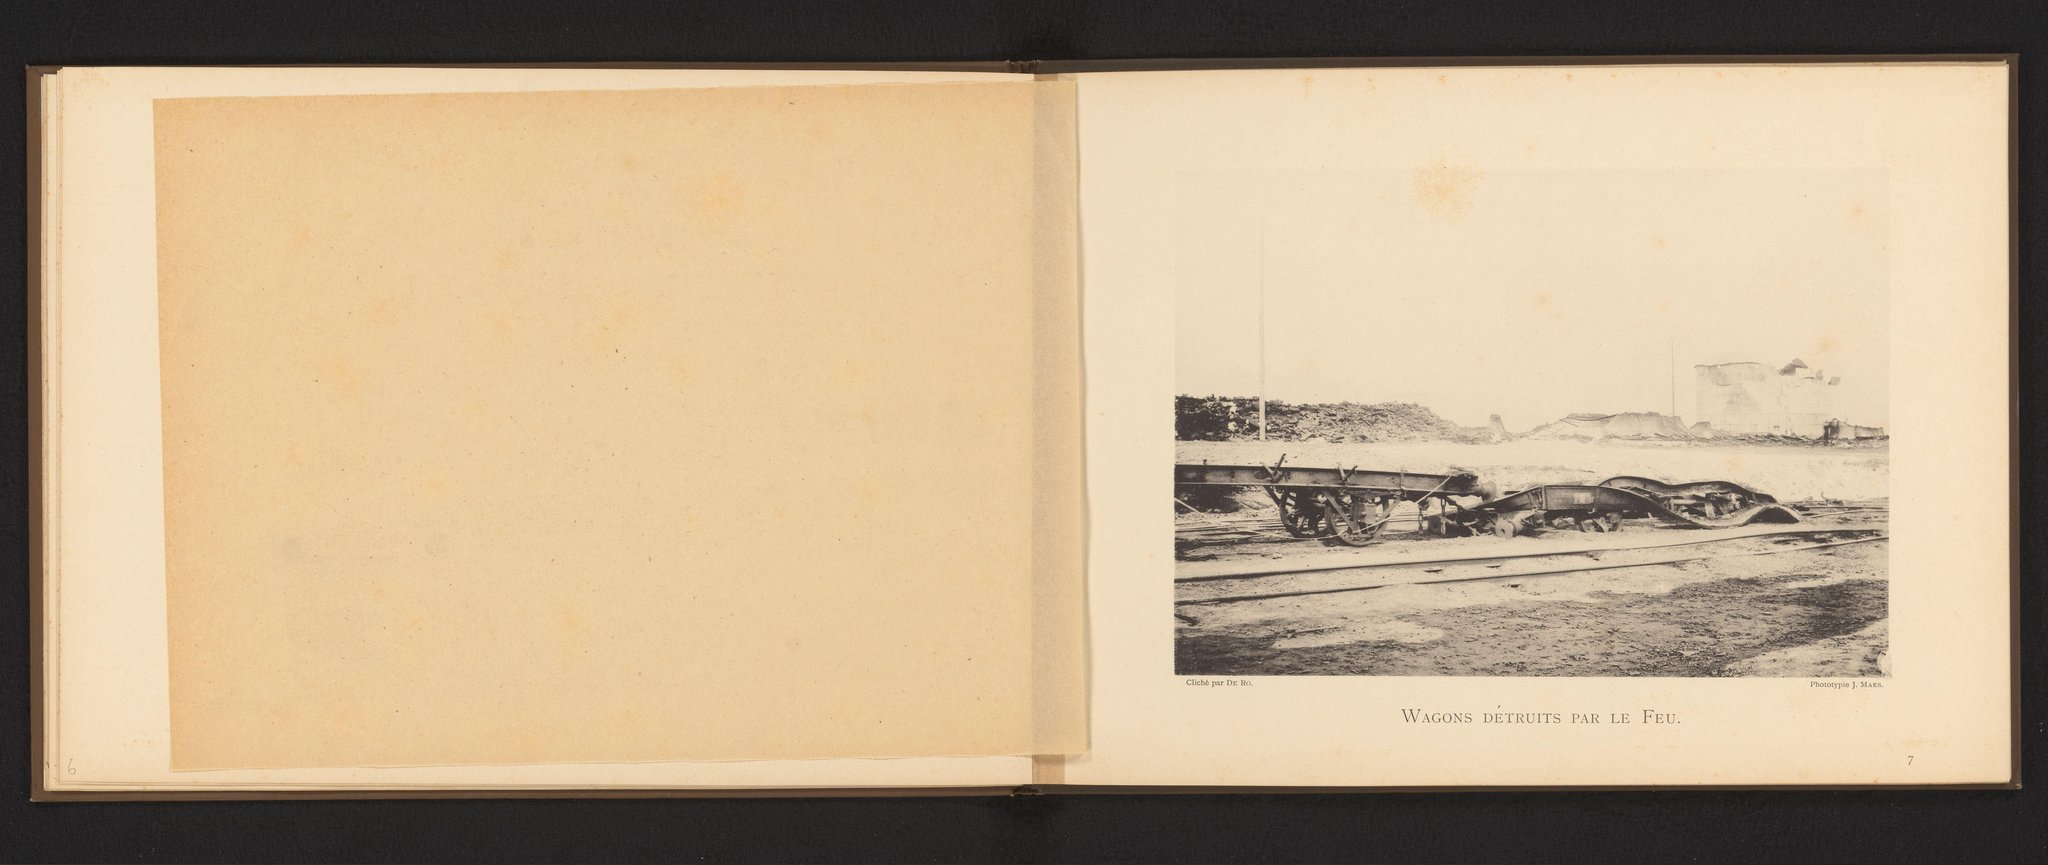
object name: page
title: Treinwagon die is verwoest door de brand na een ontploffing van een munitiefabriek in Oosterweel bij Antwerpen in 1889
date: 1889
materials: paper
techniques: photograph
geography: antwerp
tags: railway wagon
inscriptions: number: ‘7’